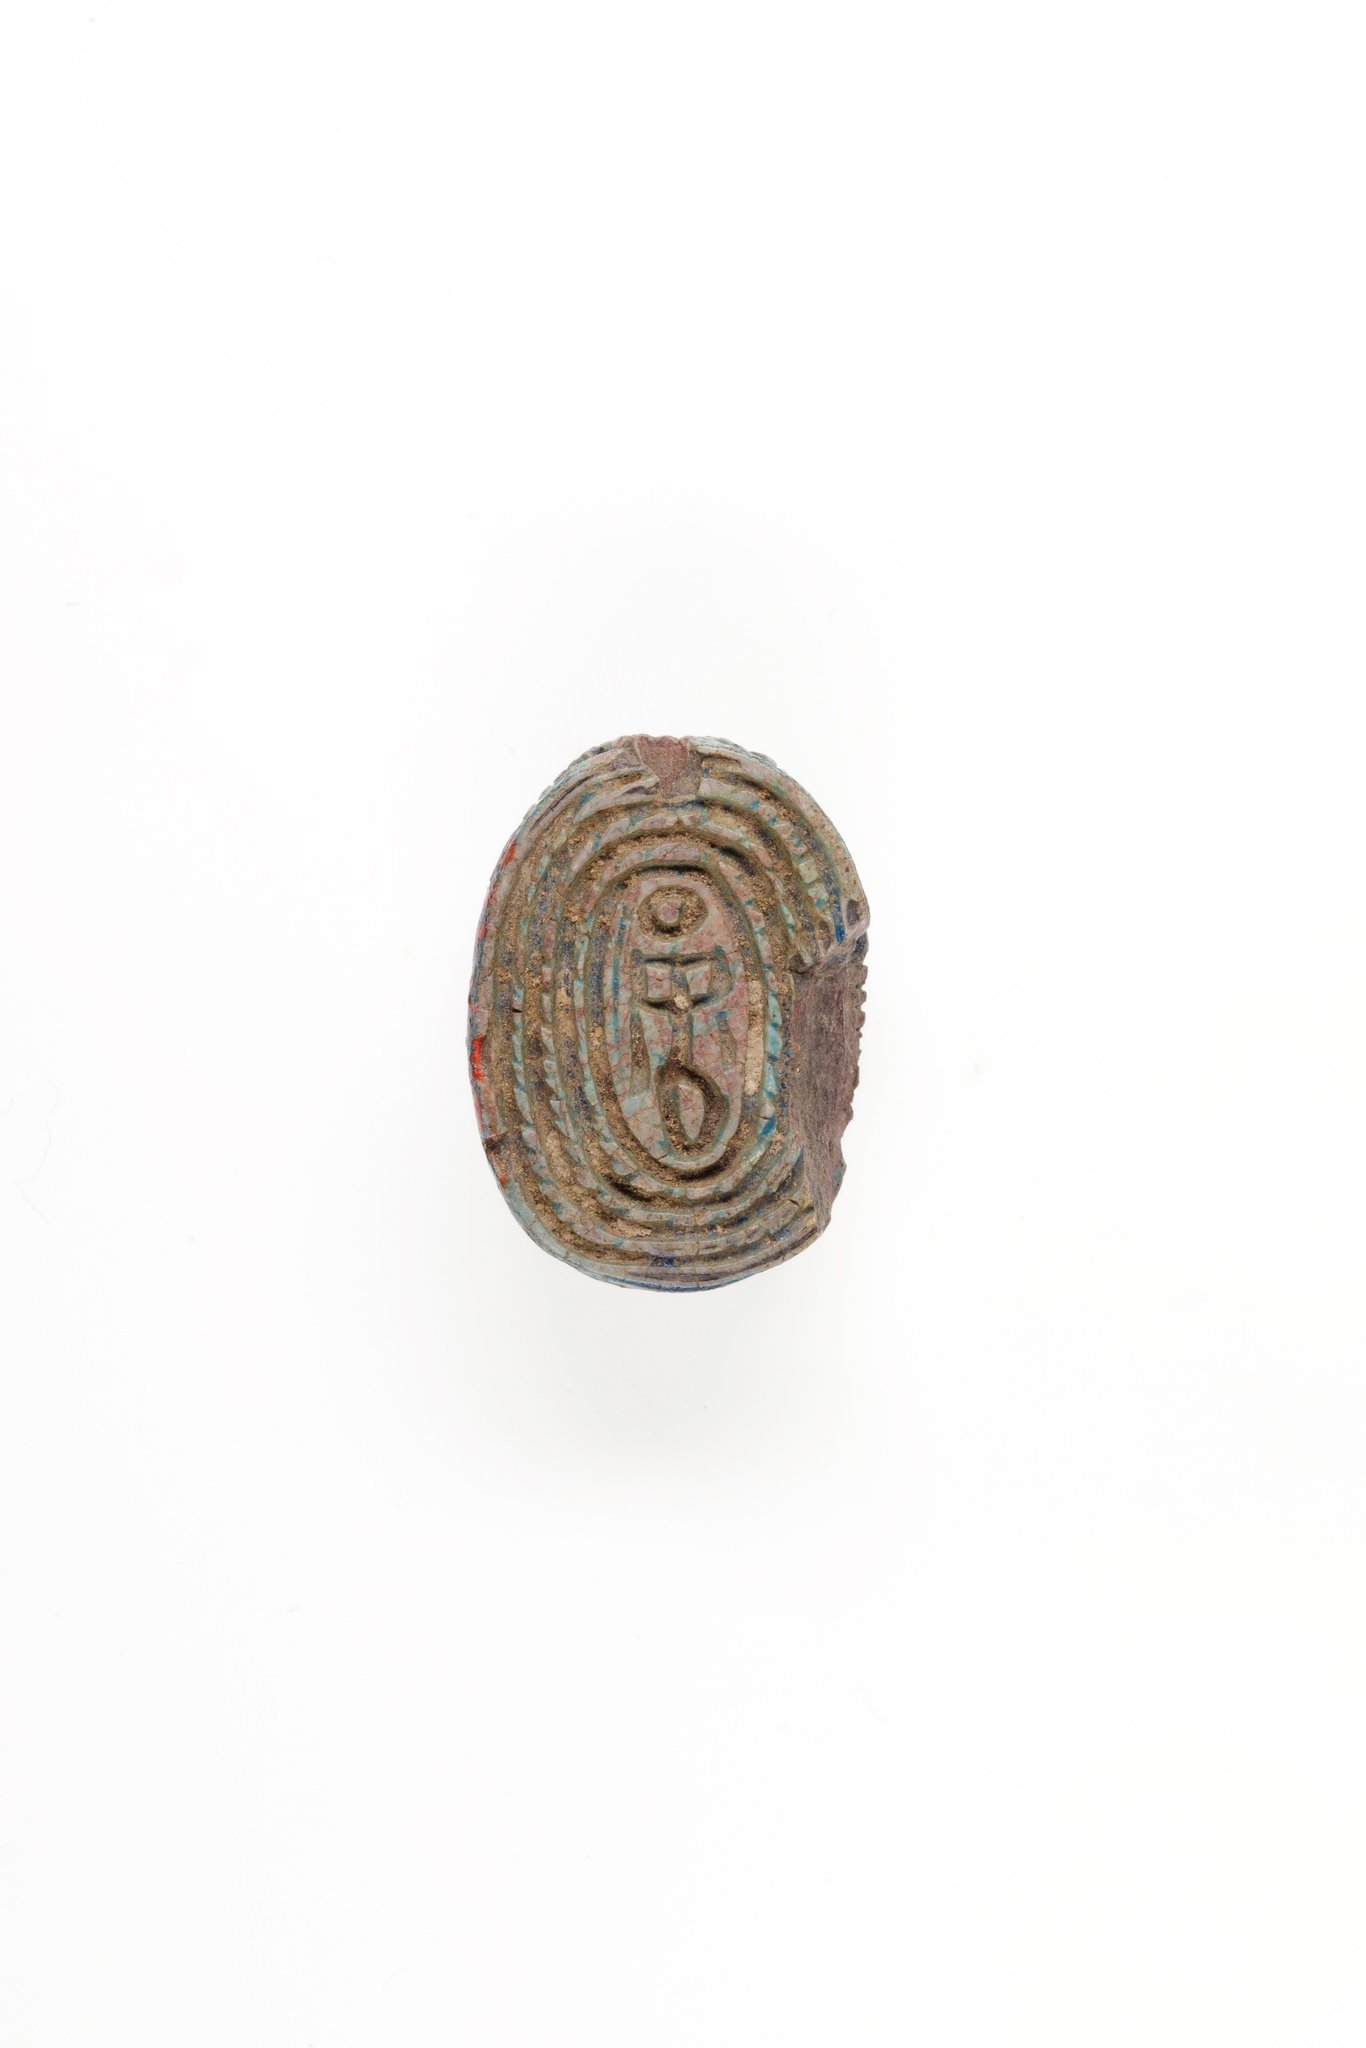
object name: scarab, nefer re, rope border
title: Scarab Inscribed with Hieroglyphs in a Rope Border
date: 1740-1640 BCE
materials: stone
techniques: glazing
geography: egypt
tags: scarabs